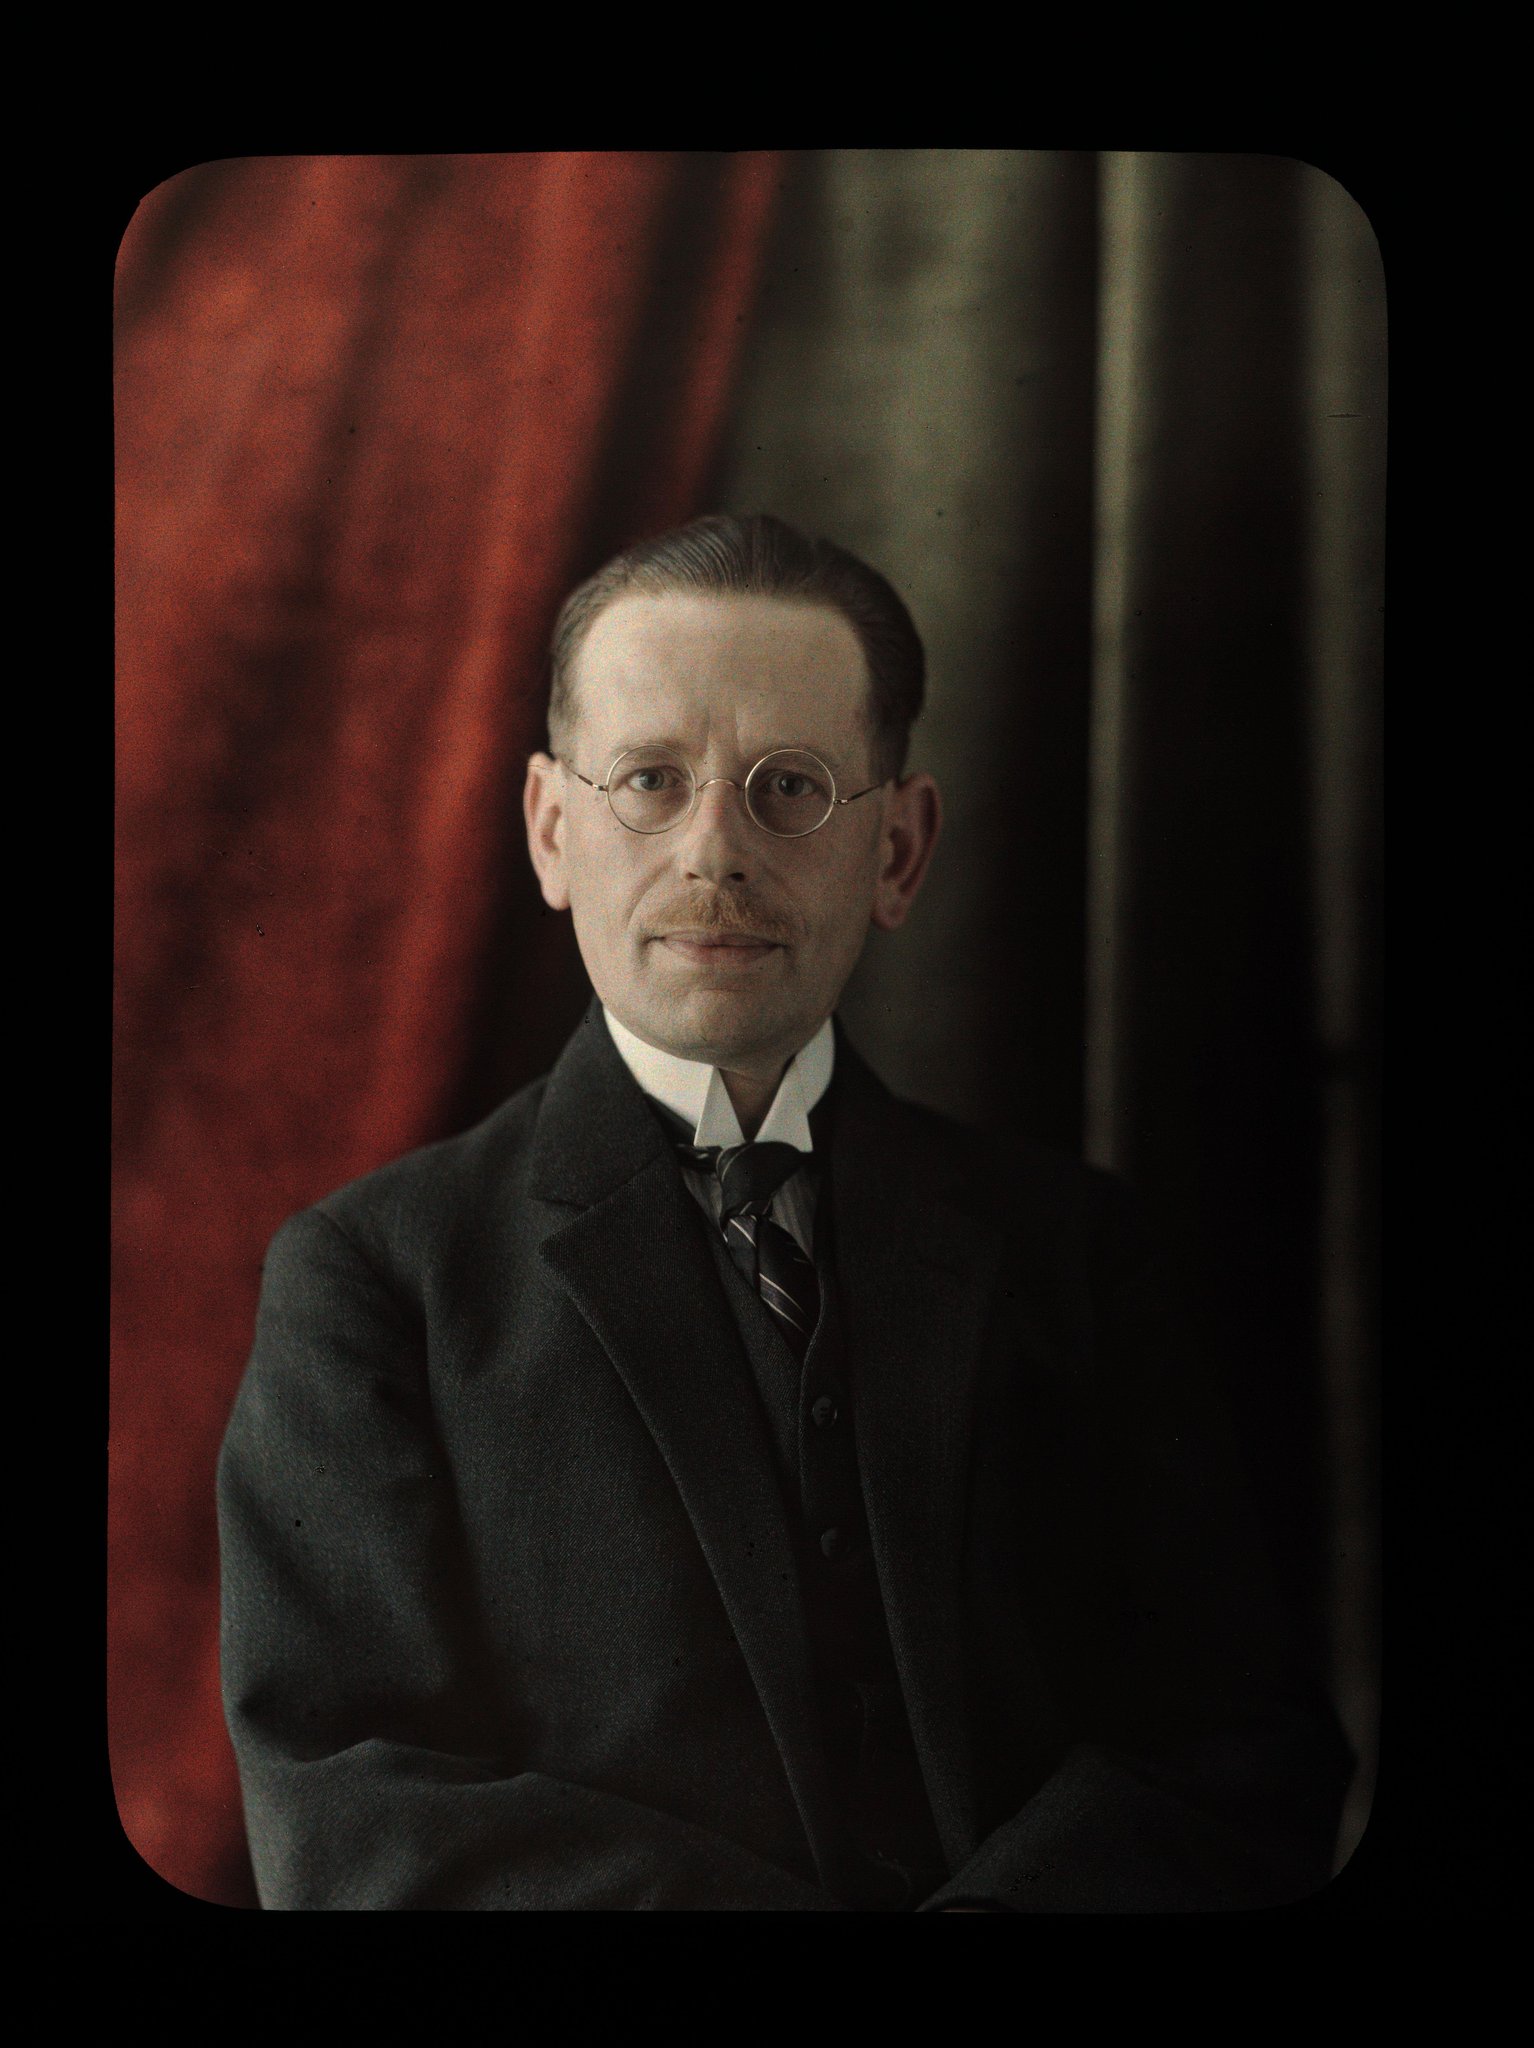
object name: photograph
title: Potrait of a Man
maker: Anonymous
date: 1907-1930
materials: glass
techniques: autochrome process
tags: historical persons not known by name